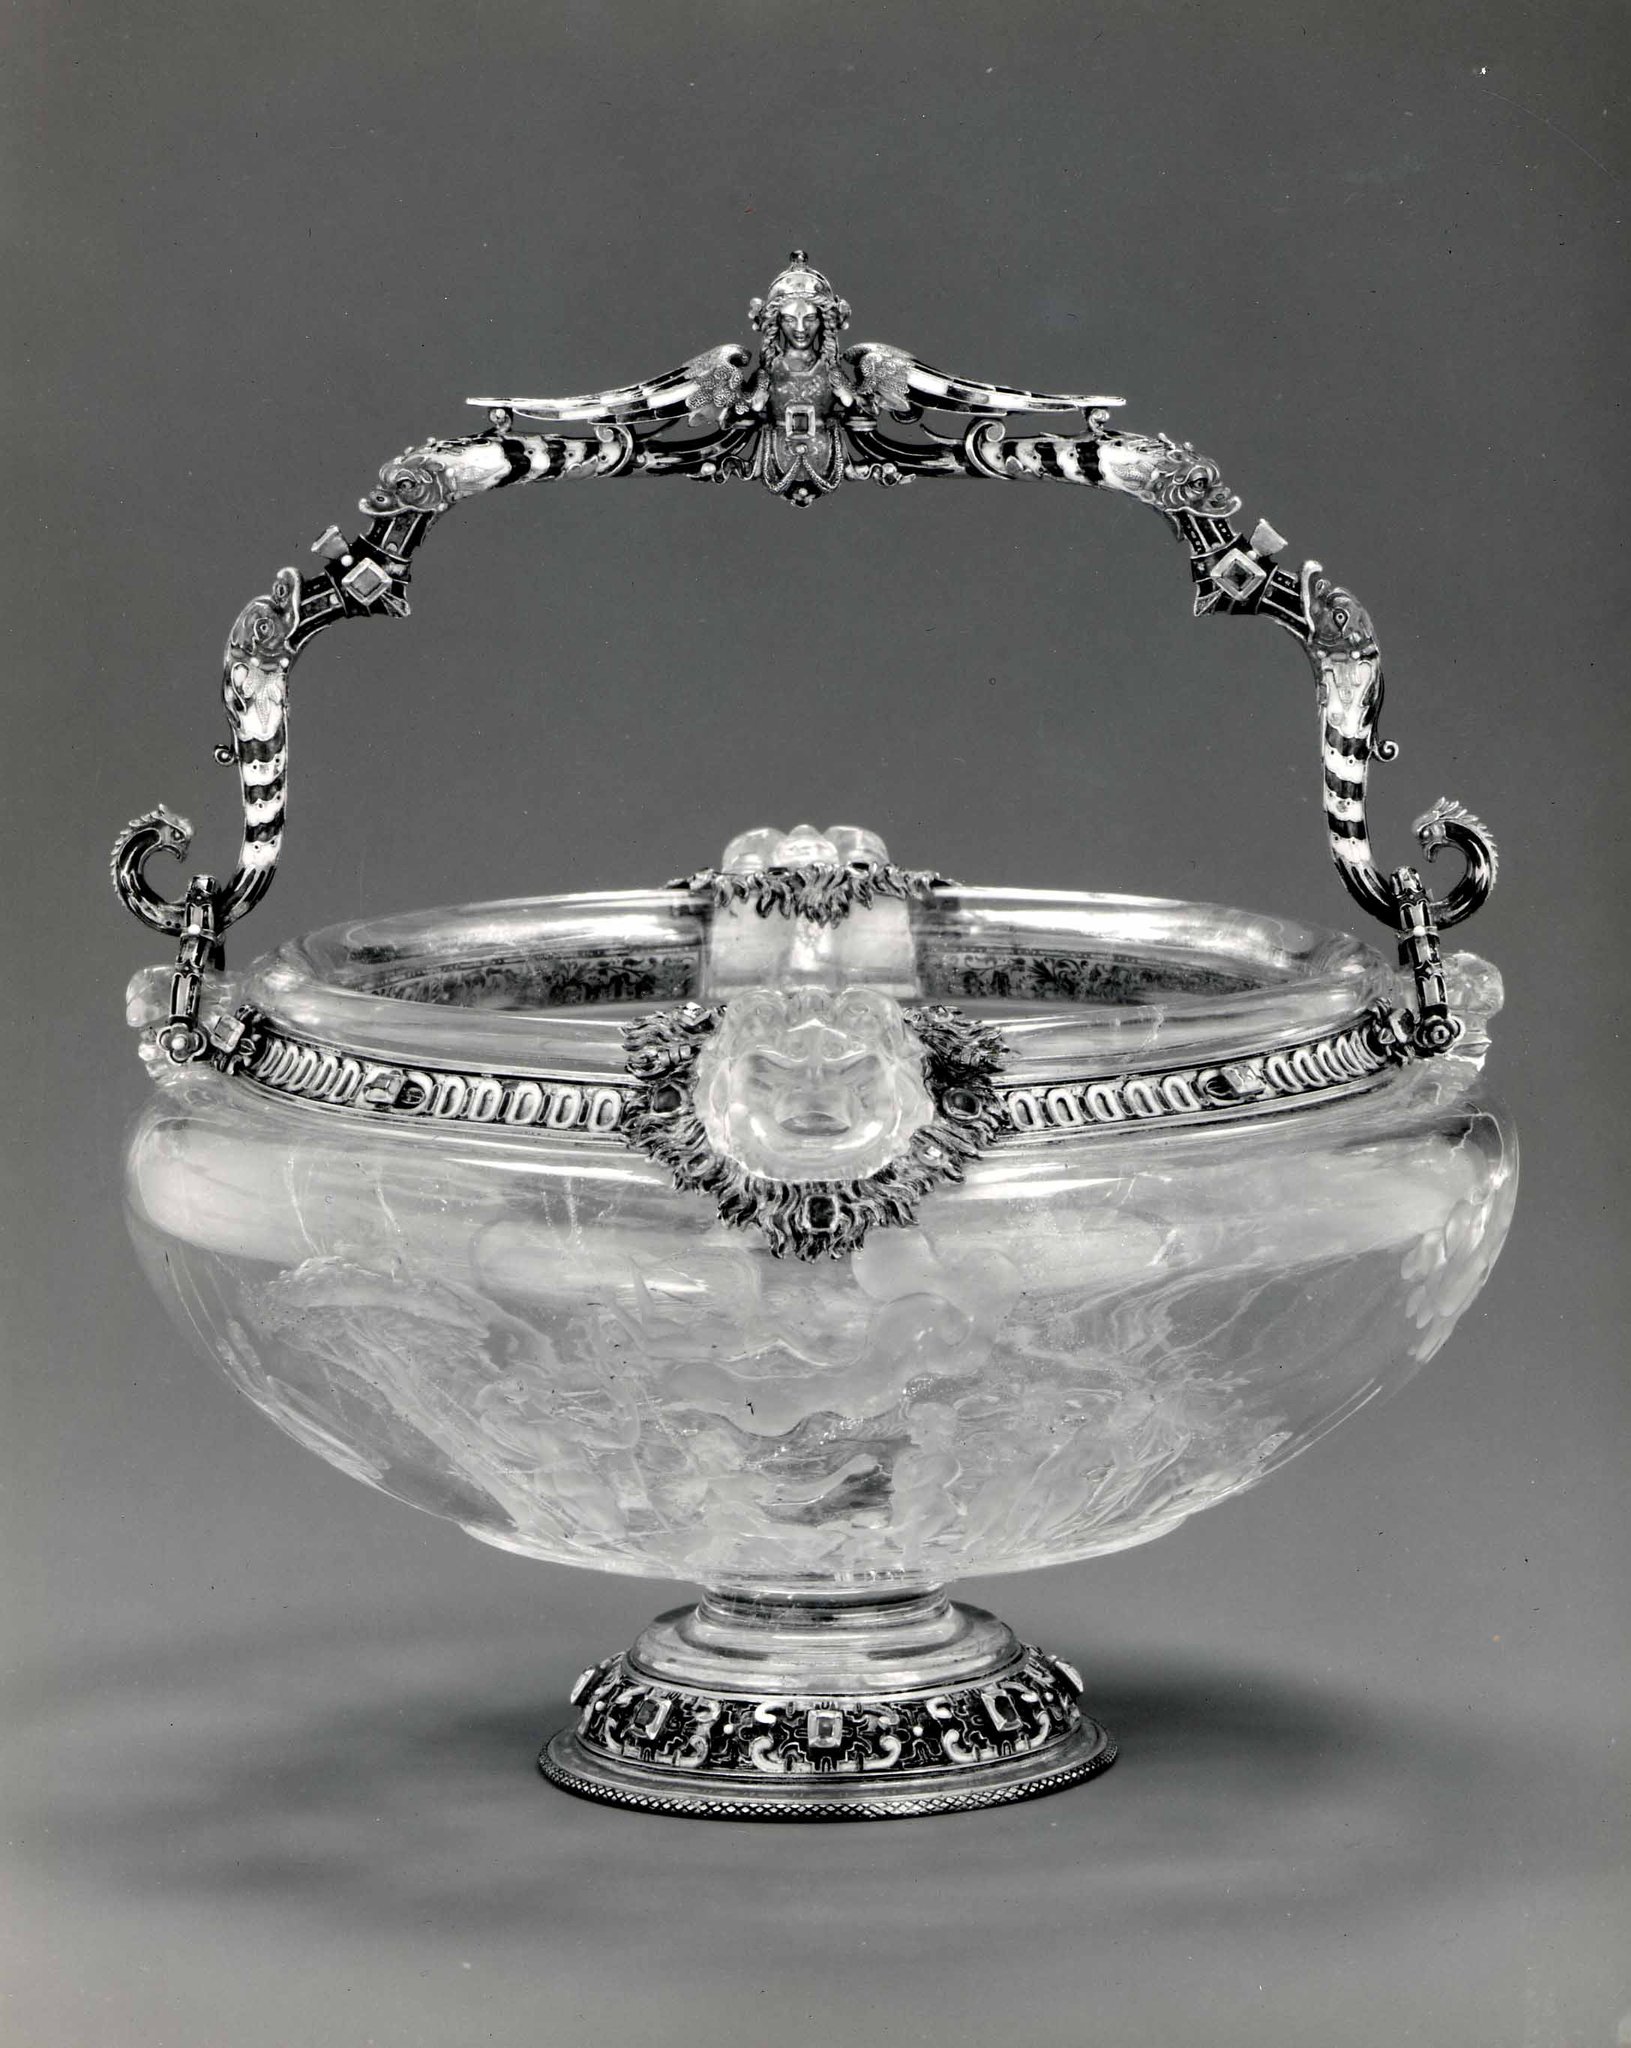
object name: bowl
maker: italian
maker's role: artist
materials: diamond, gold, quartz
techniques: cutting, enamel